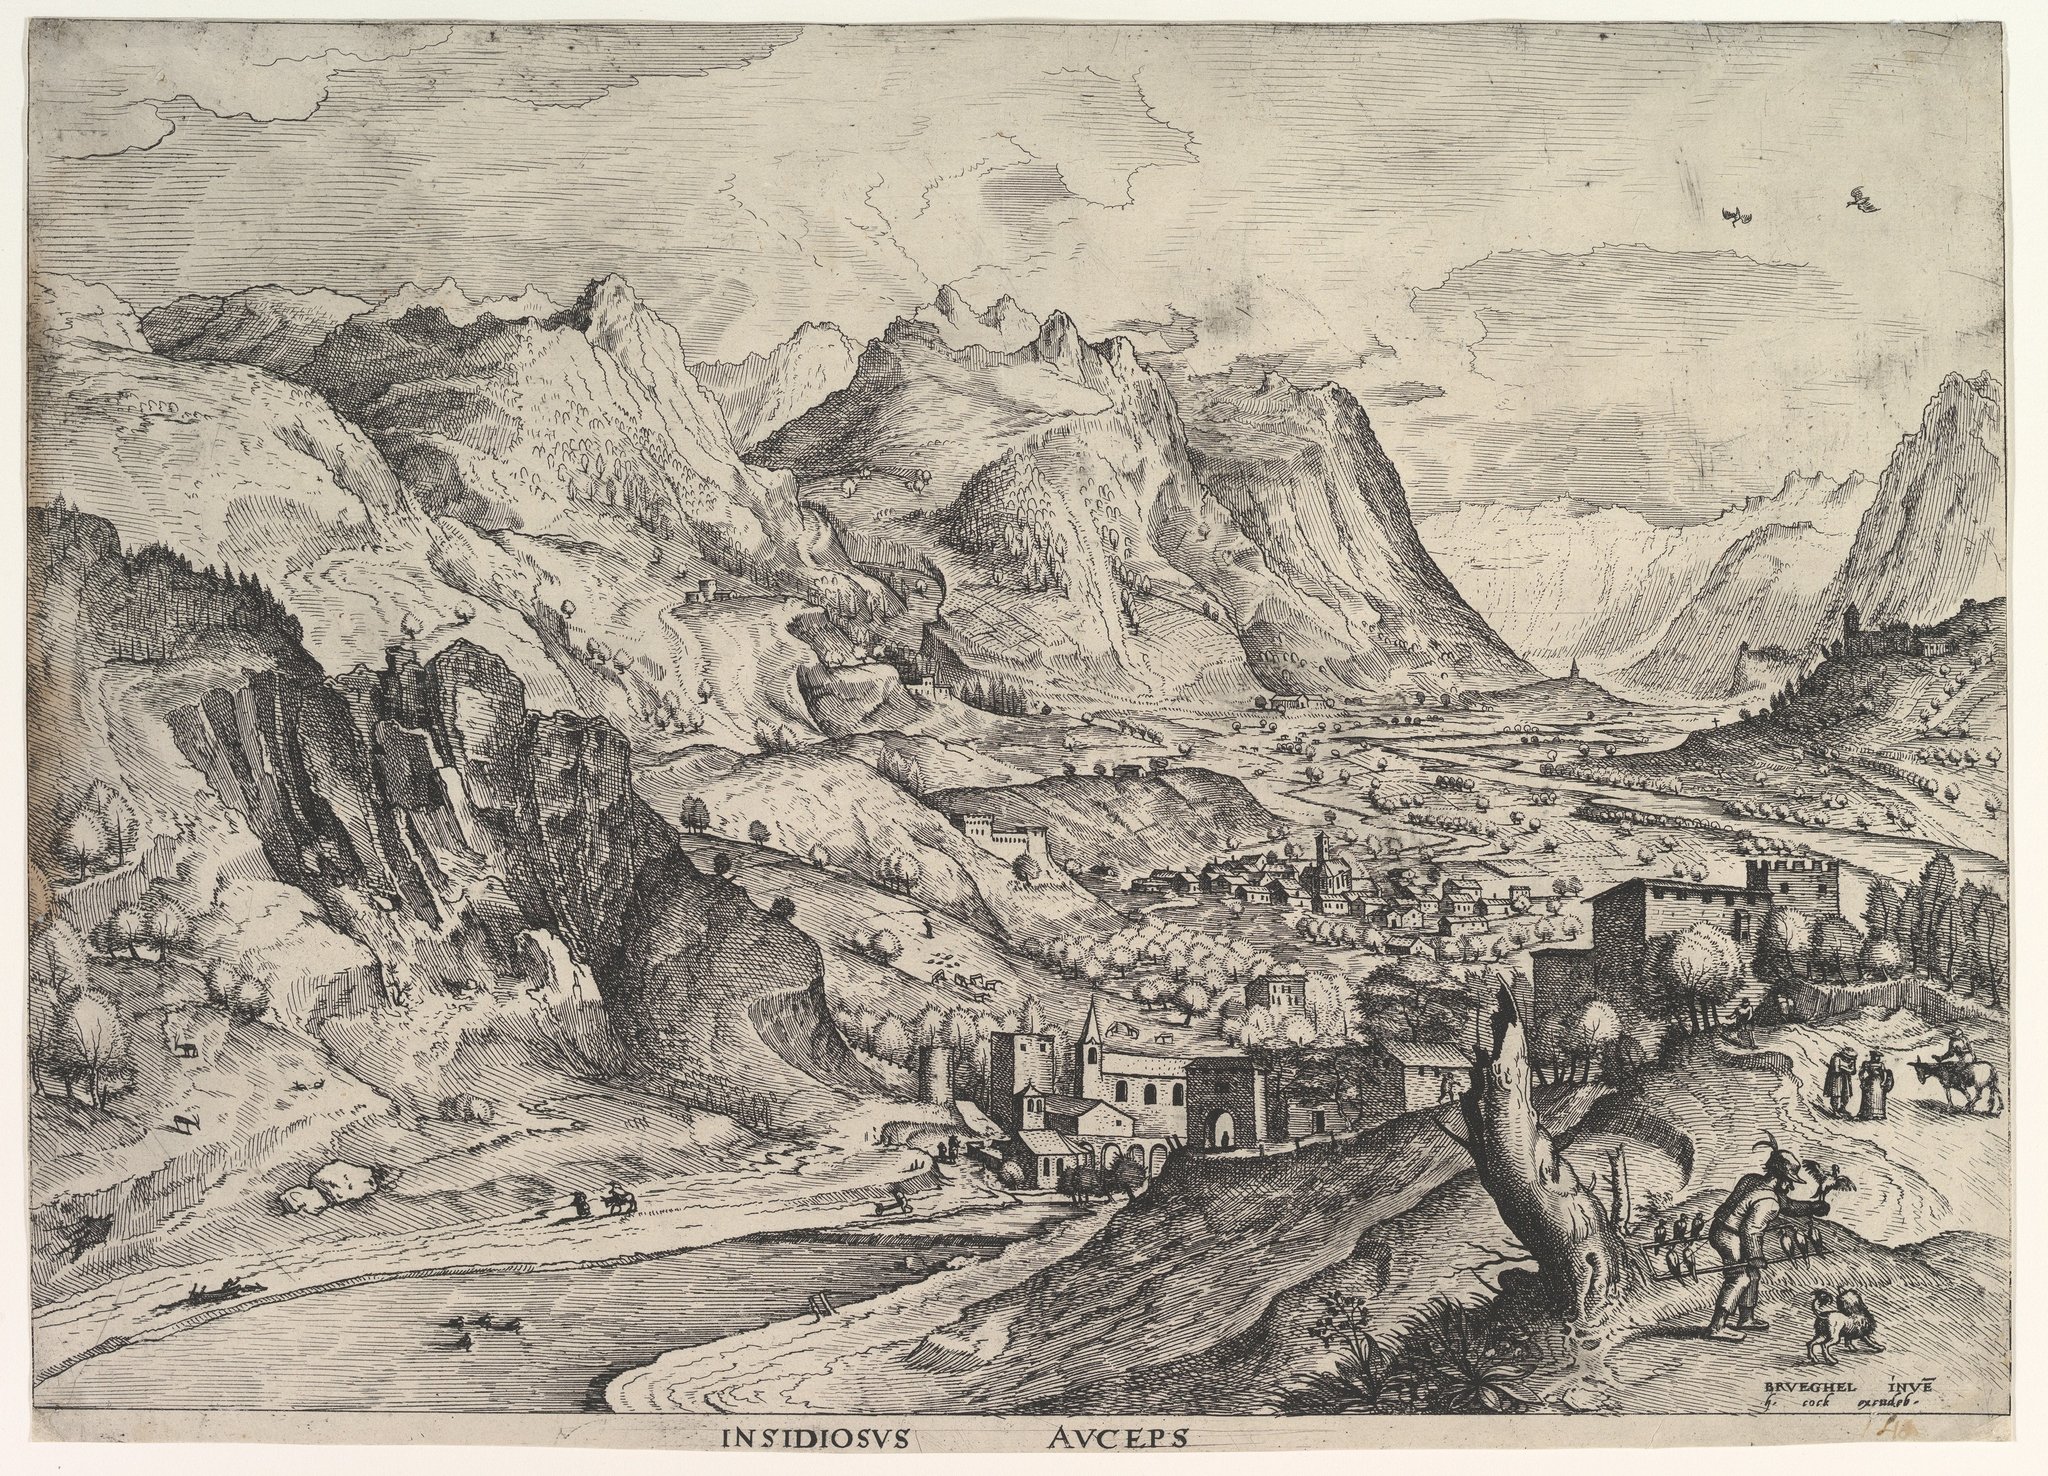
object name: print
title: The Crafty Bird-Catcher (Insidiosus auceps), from "The Large Landscapes"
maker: johannes van doetecum i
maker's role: artist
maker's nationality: netherlandish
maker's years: 1528-1605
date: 1555-1556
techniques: engraving, etching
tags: hills,landscapes